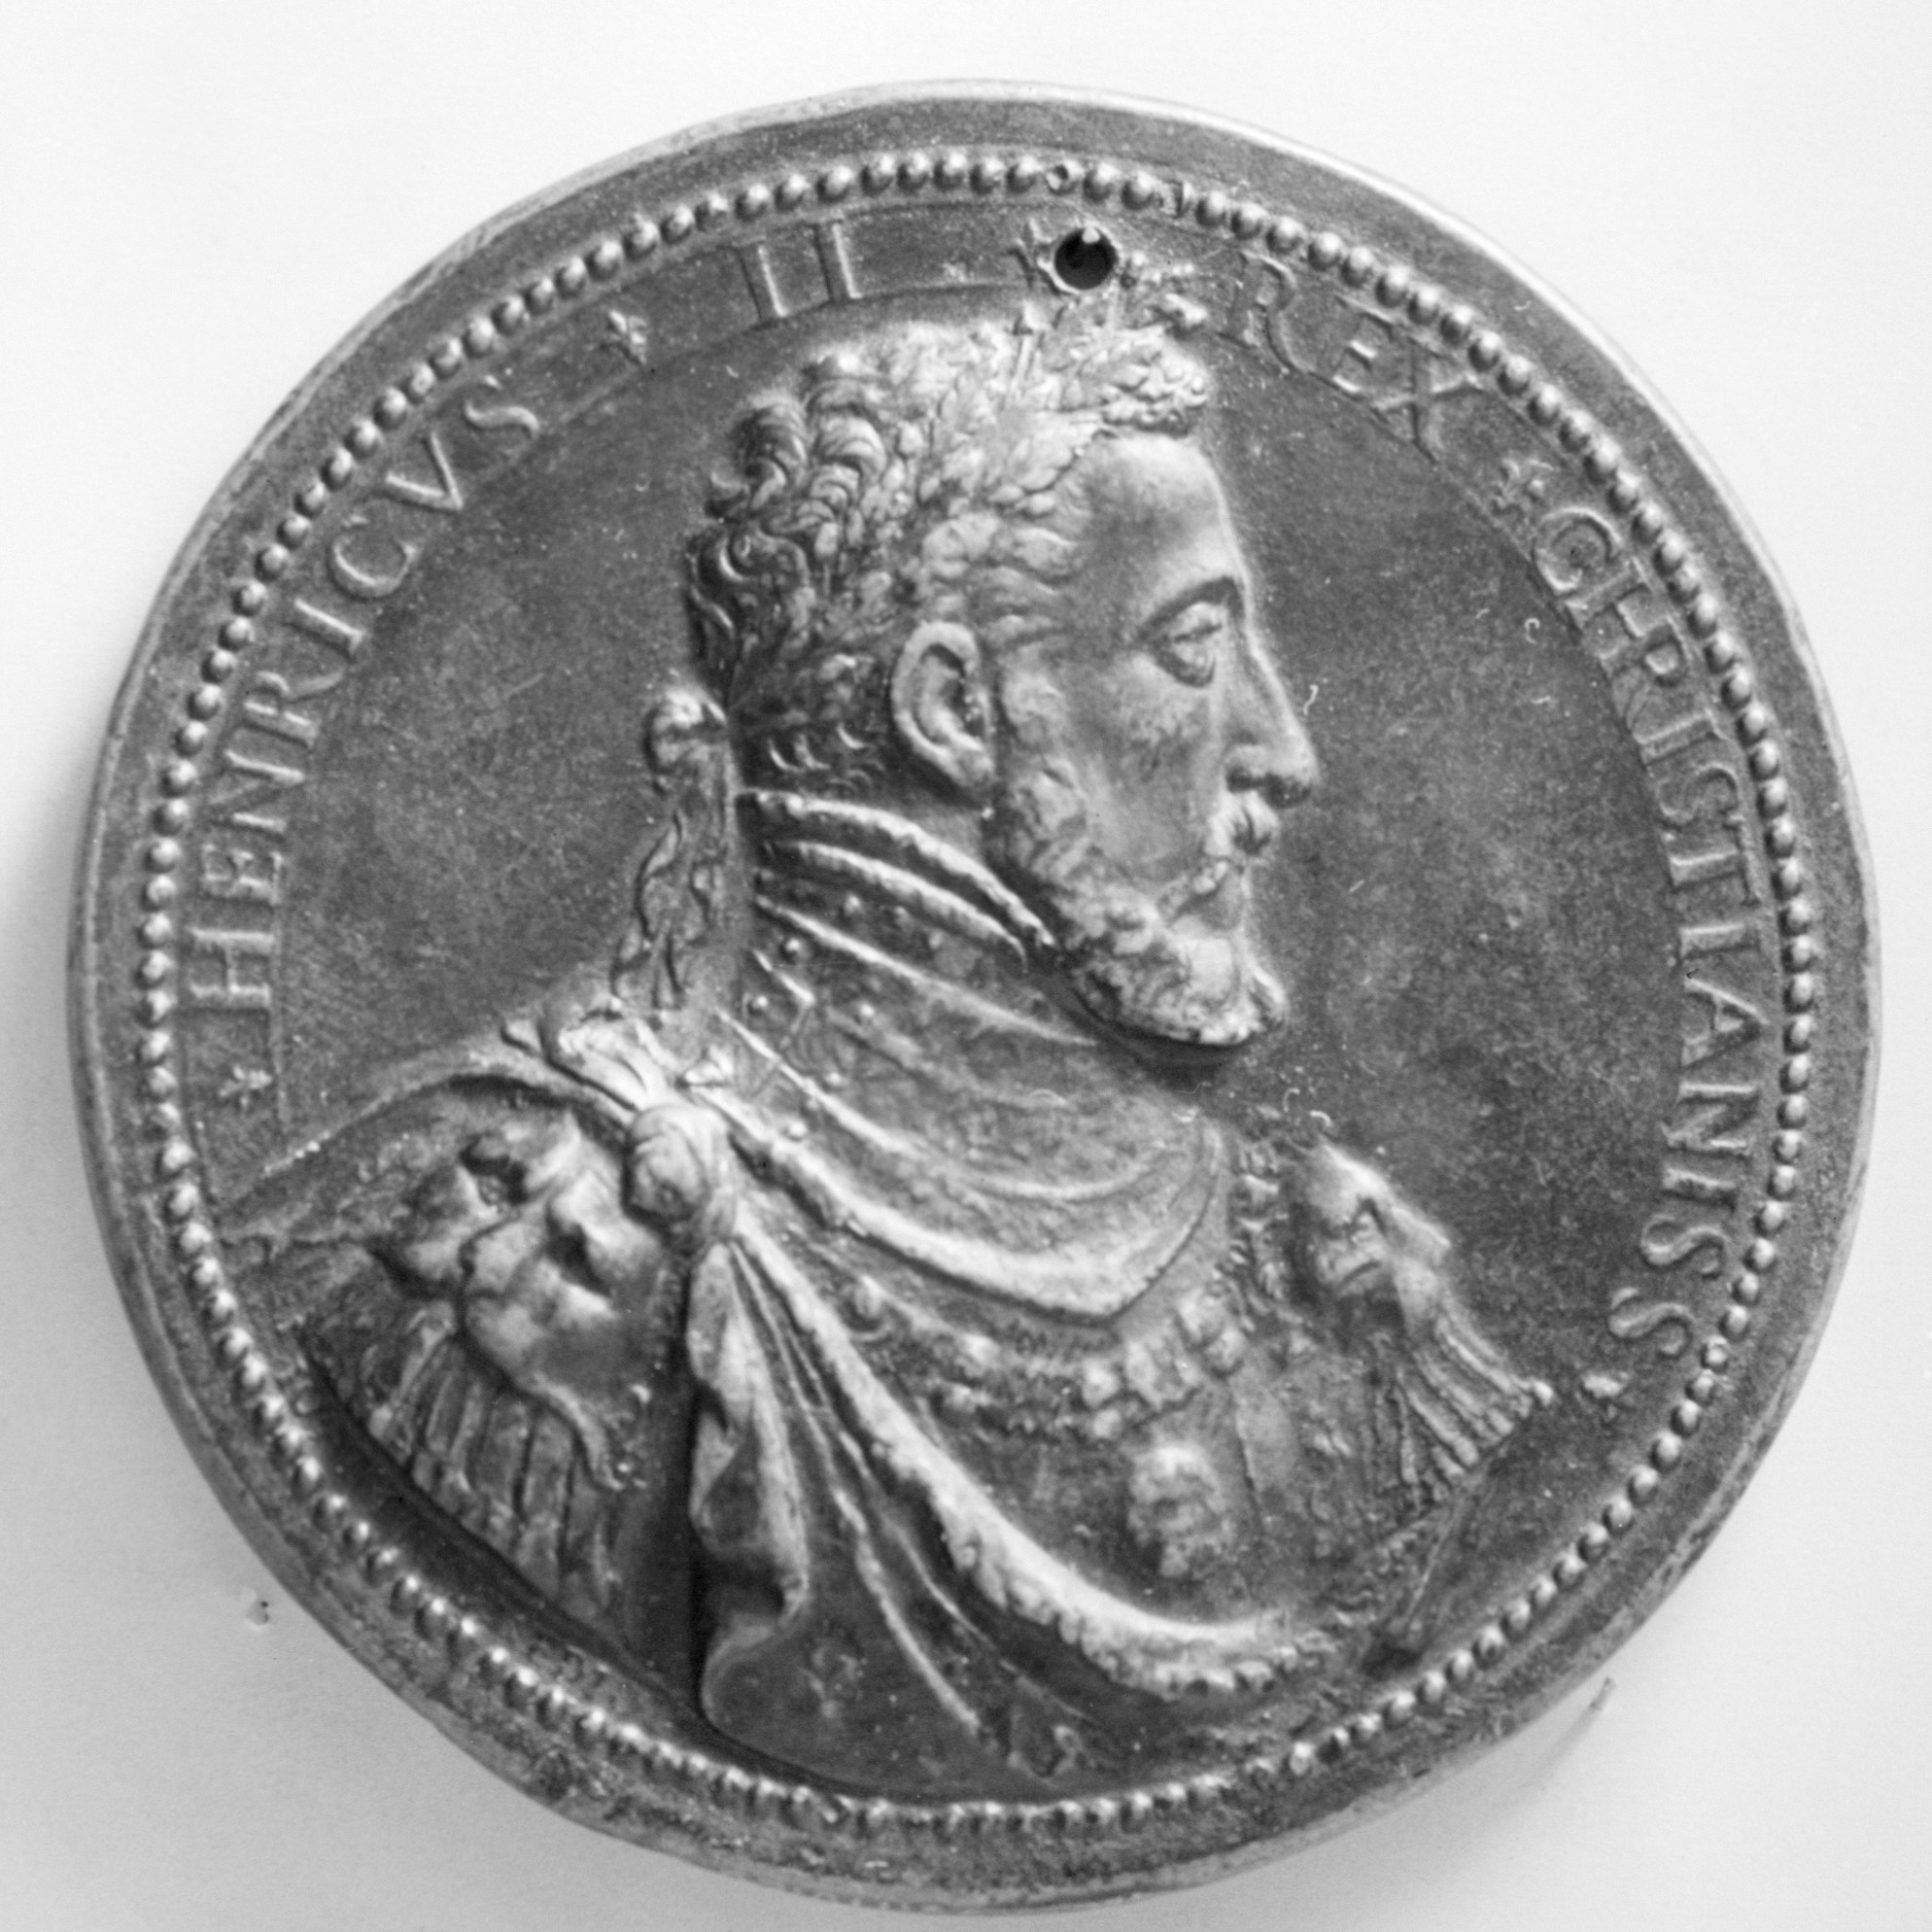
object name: medal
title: Henry II of France (b. 1519, r. 1547–59), Commemorating the Capture of Calais, 1558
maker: giovanni antonio de' rossi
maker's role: artist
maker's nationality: italian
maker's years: 1517-1580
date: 1558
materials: bronze, patina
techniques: casting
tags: men,profiles,horses